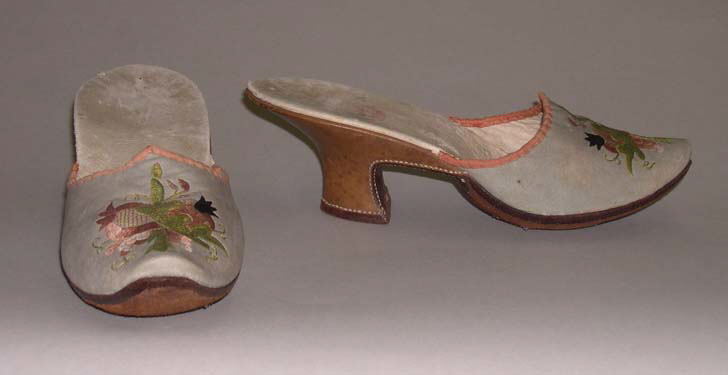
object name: mule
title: Mules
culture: european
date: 1750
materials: leather, silk